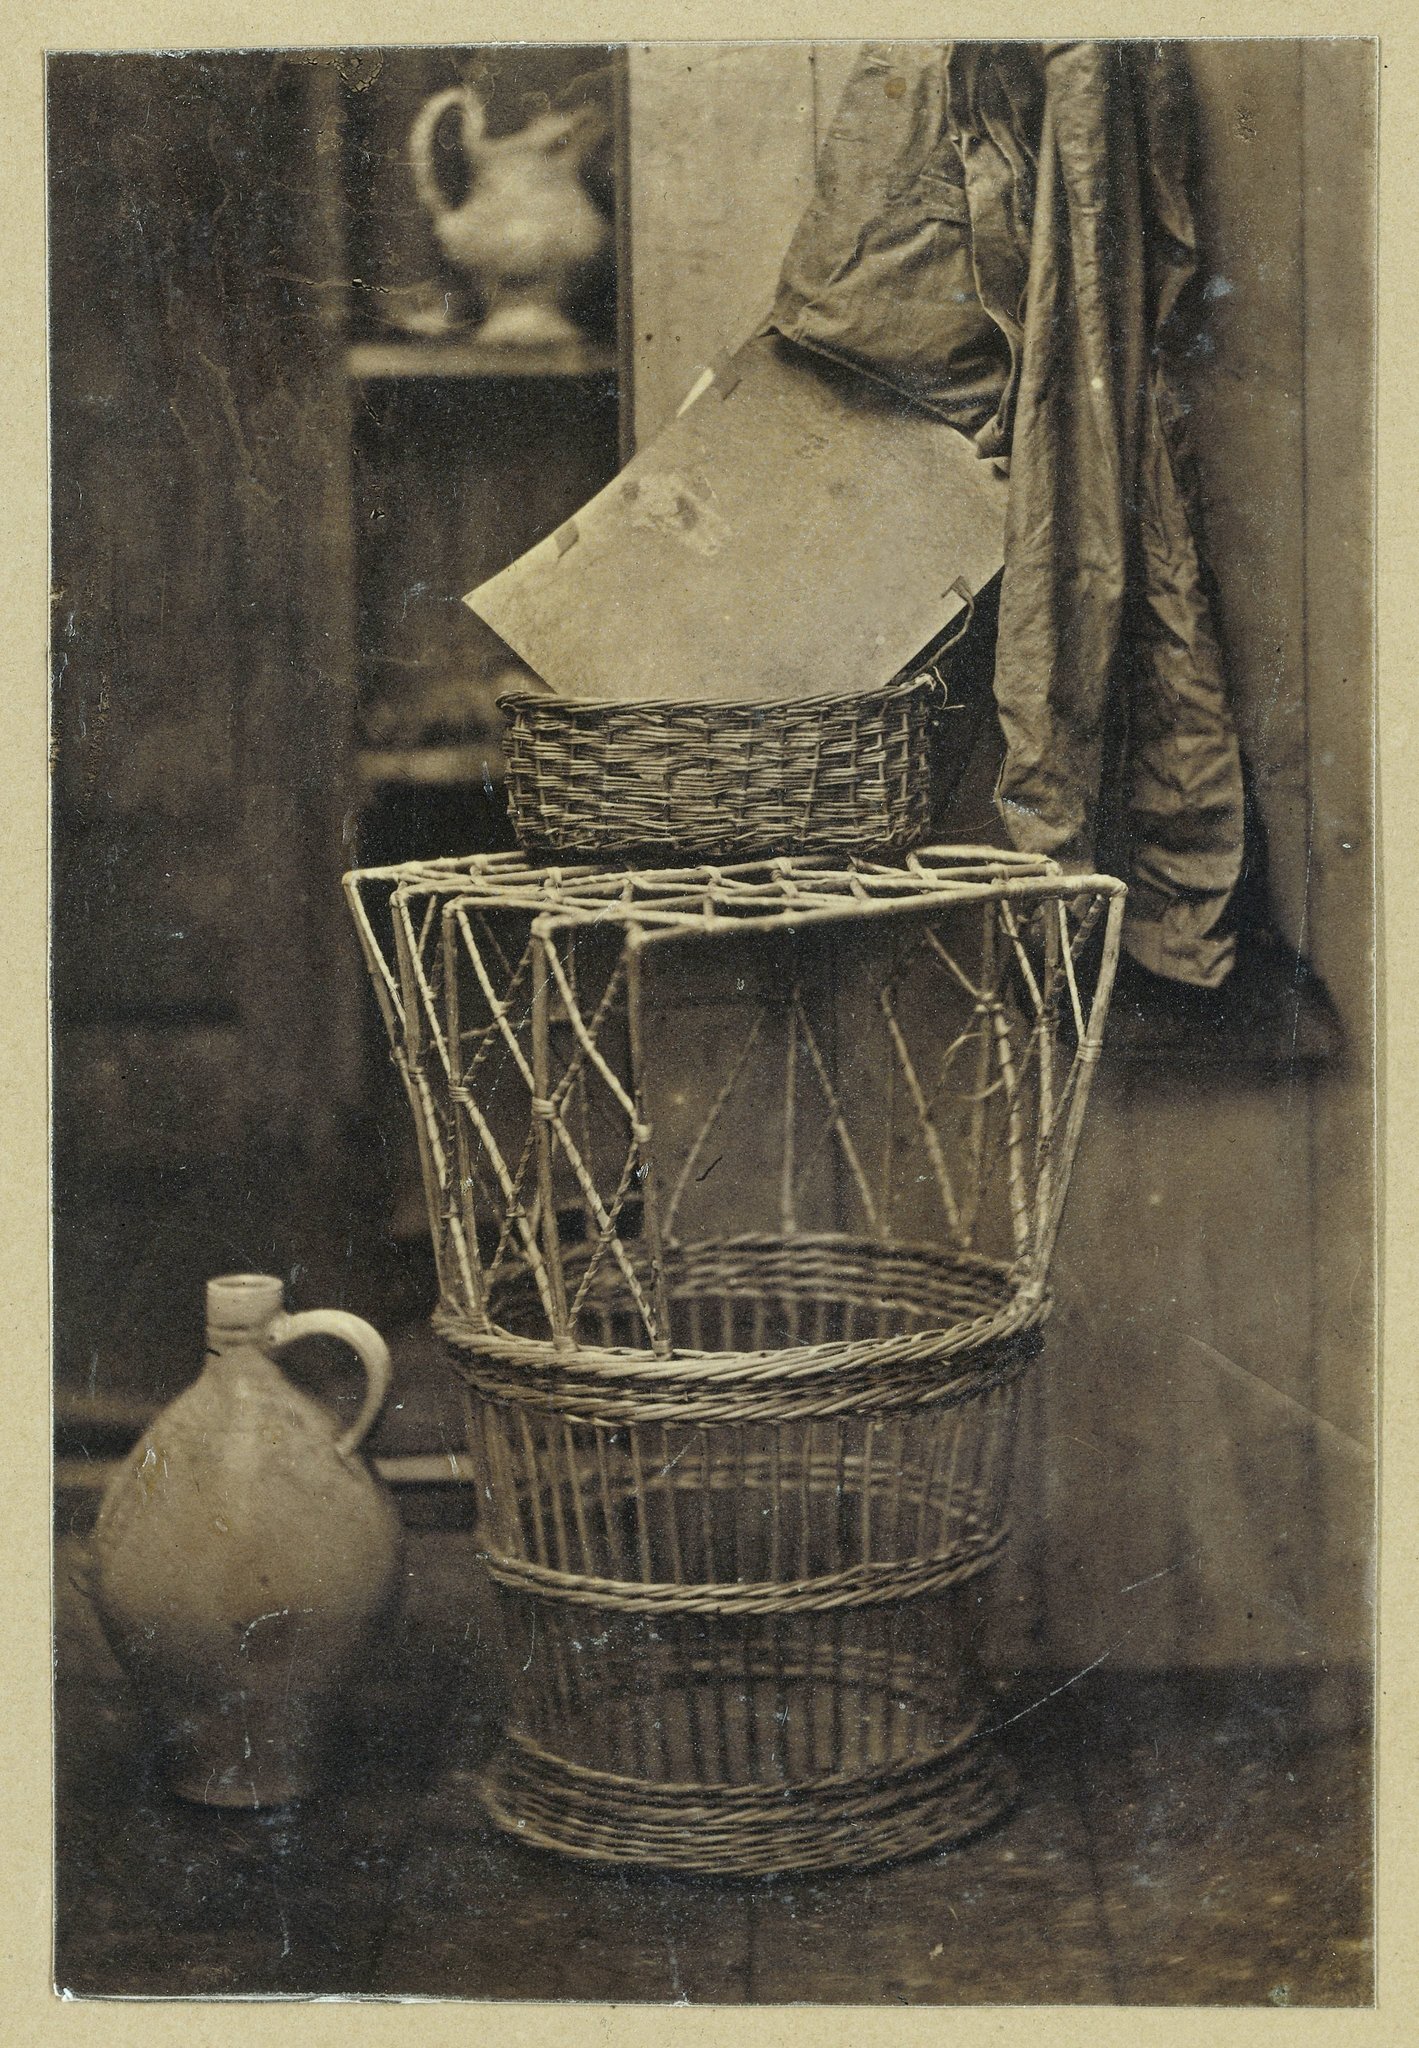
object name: photograph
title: Stilleven met vuurmand, kruik, kan en portfolio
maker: eduard isaac asser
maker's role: amateurfotograaf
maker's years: 1809-1894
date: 1855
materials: cardboard, paper, photographic support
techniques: salted paper print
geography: amsterdam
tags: still life of related objects, netherlands